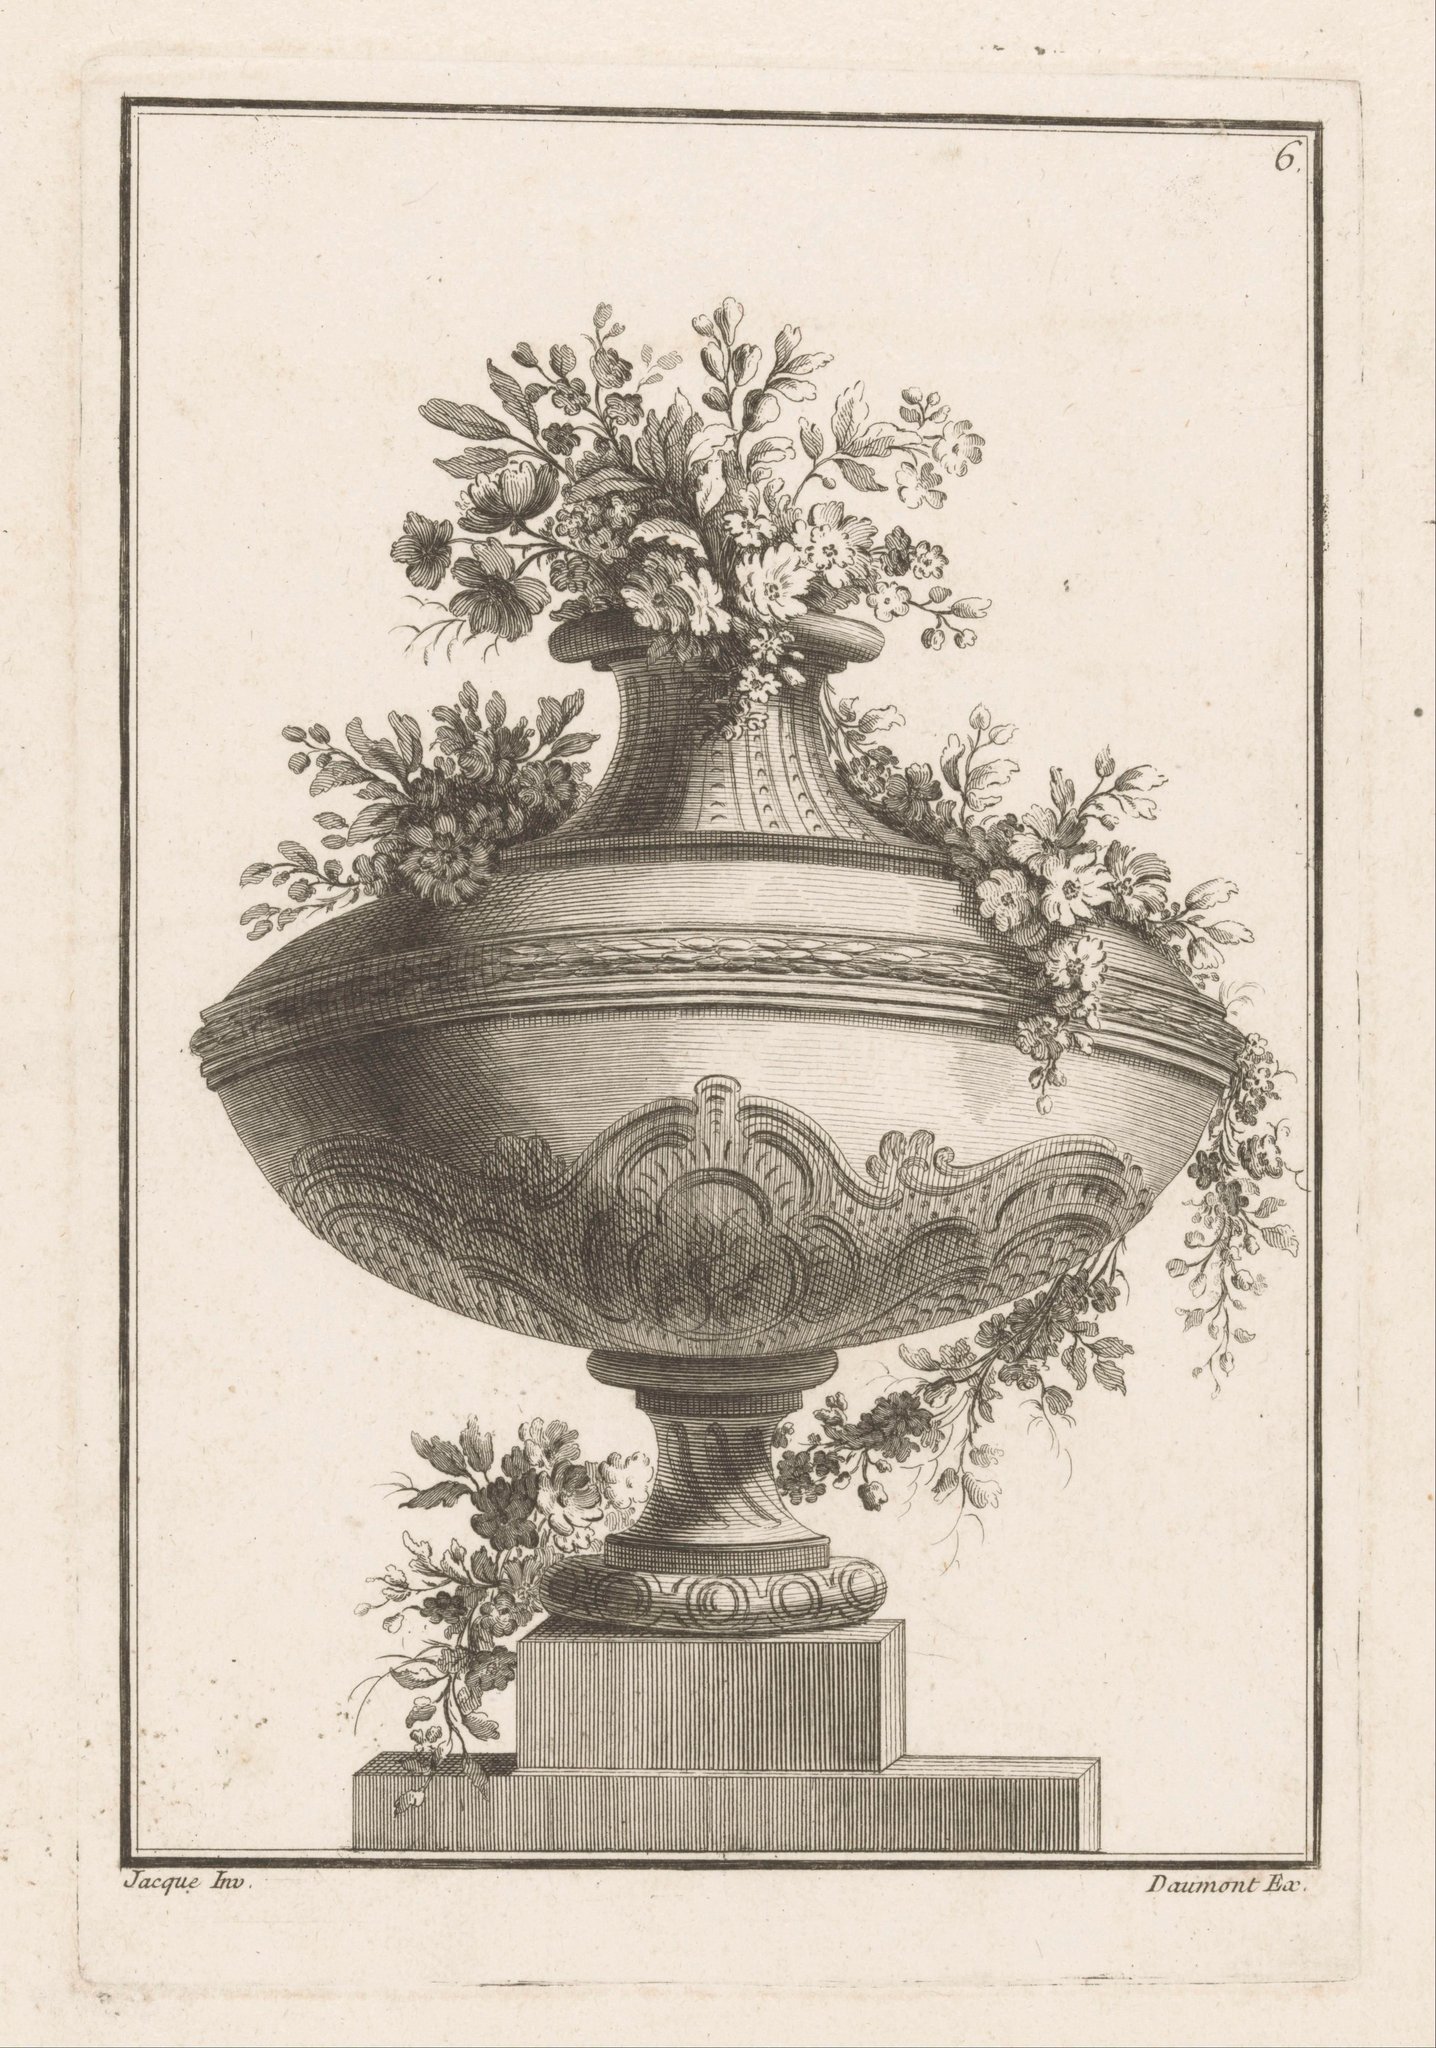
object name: print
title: Vases Nouveaux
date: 1745-1775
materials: paper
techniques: engraving, etching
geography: paris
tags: flowers, vase ~ ornament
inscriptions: collector's mark: Lugt 2228, collector's mark: Lugt 2760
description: Een geornamenteerde vaas met bloemen rondom.